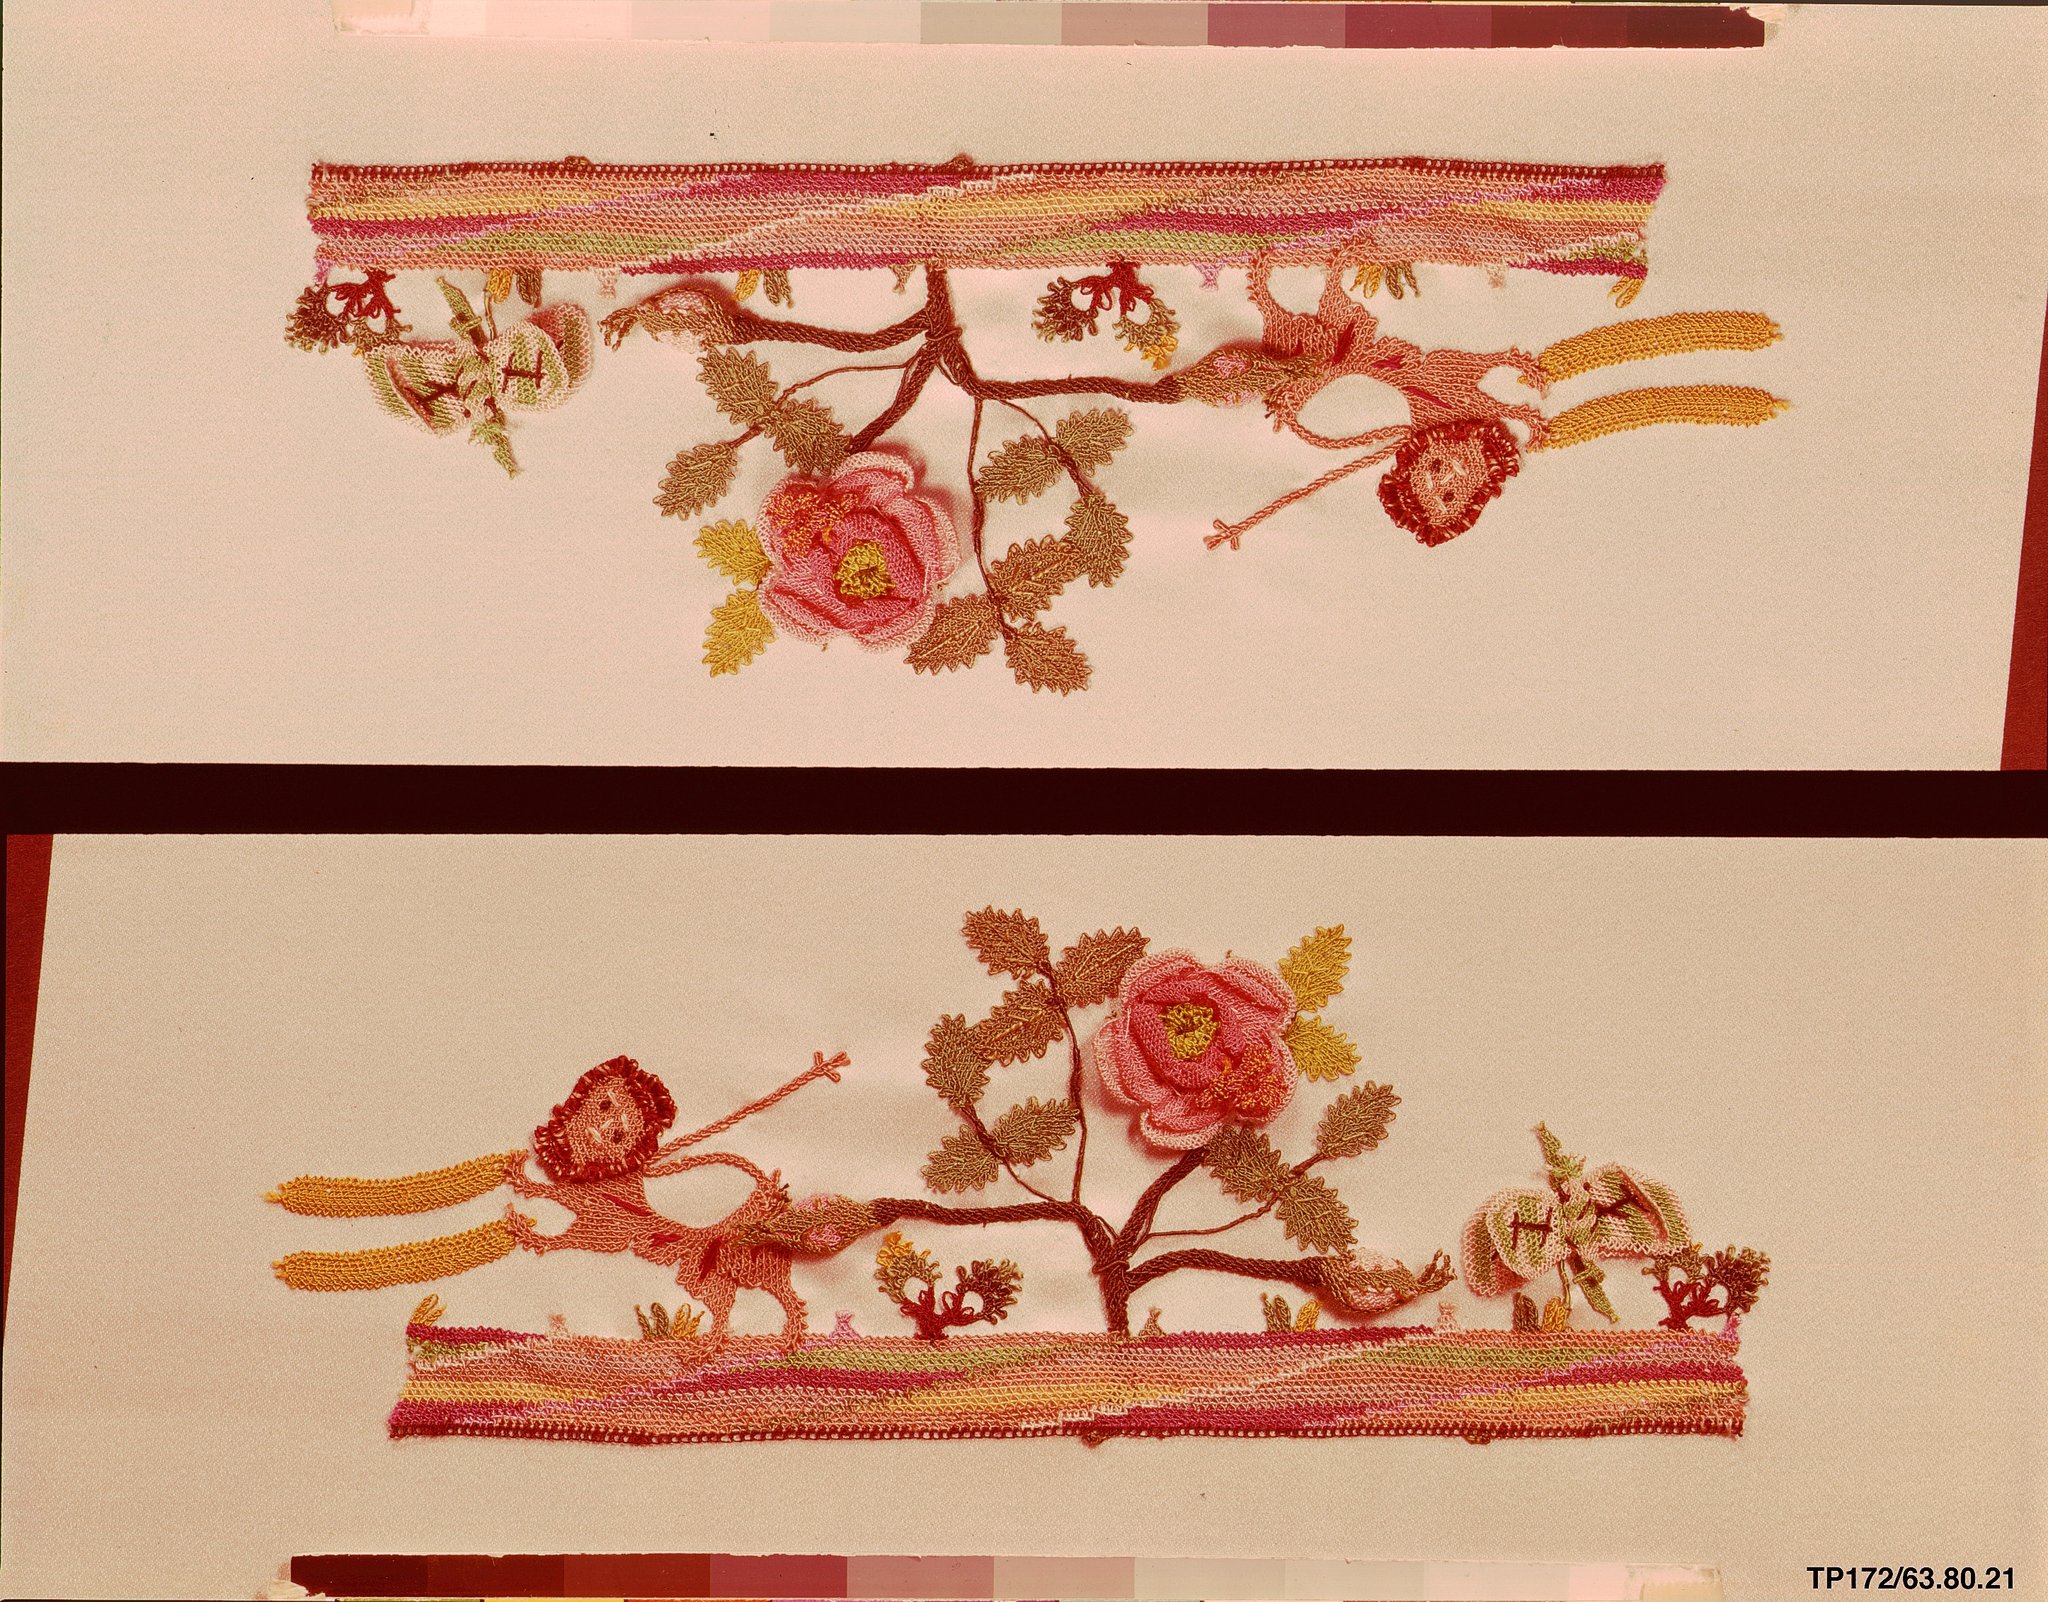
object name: piece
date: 1801-1900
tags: animals,flowers,leaves